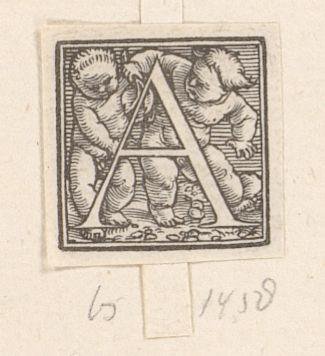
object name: book illustration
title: Latijns alfabet met kinderen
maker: hans lützelburger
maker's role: print maker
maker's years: -1526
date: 1522-1526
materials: paper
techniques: woodcut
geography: basel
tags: initial, cupids: 'amores', 'amoretti', 'putti'